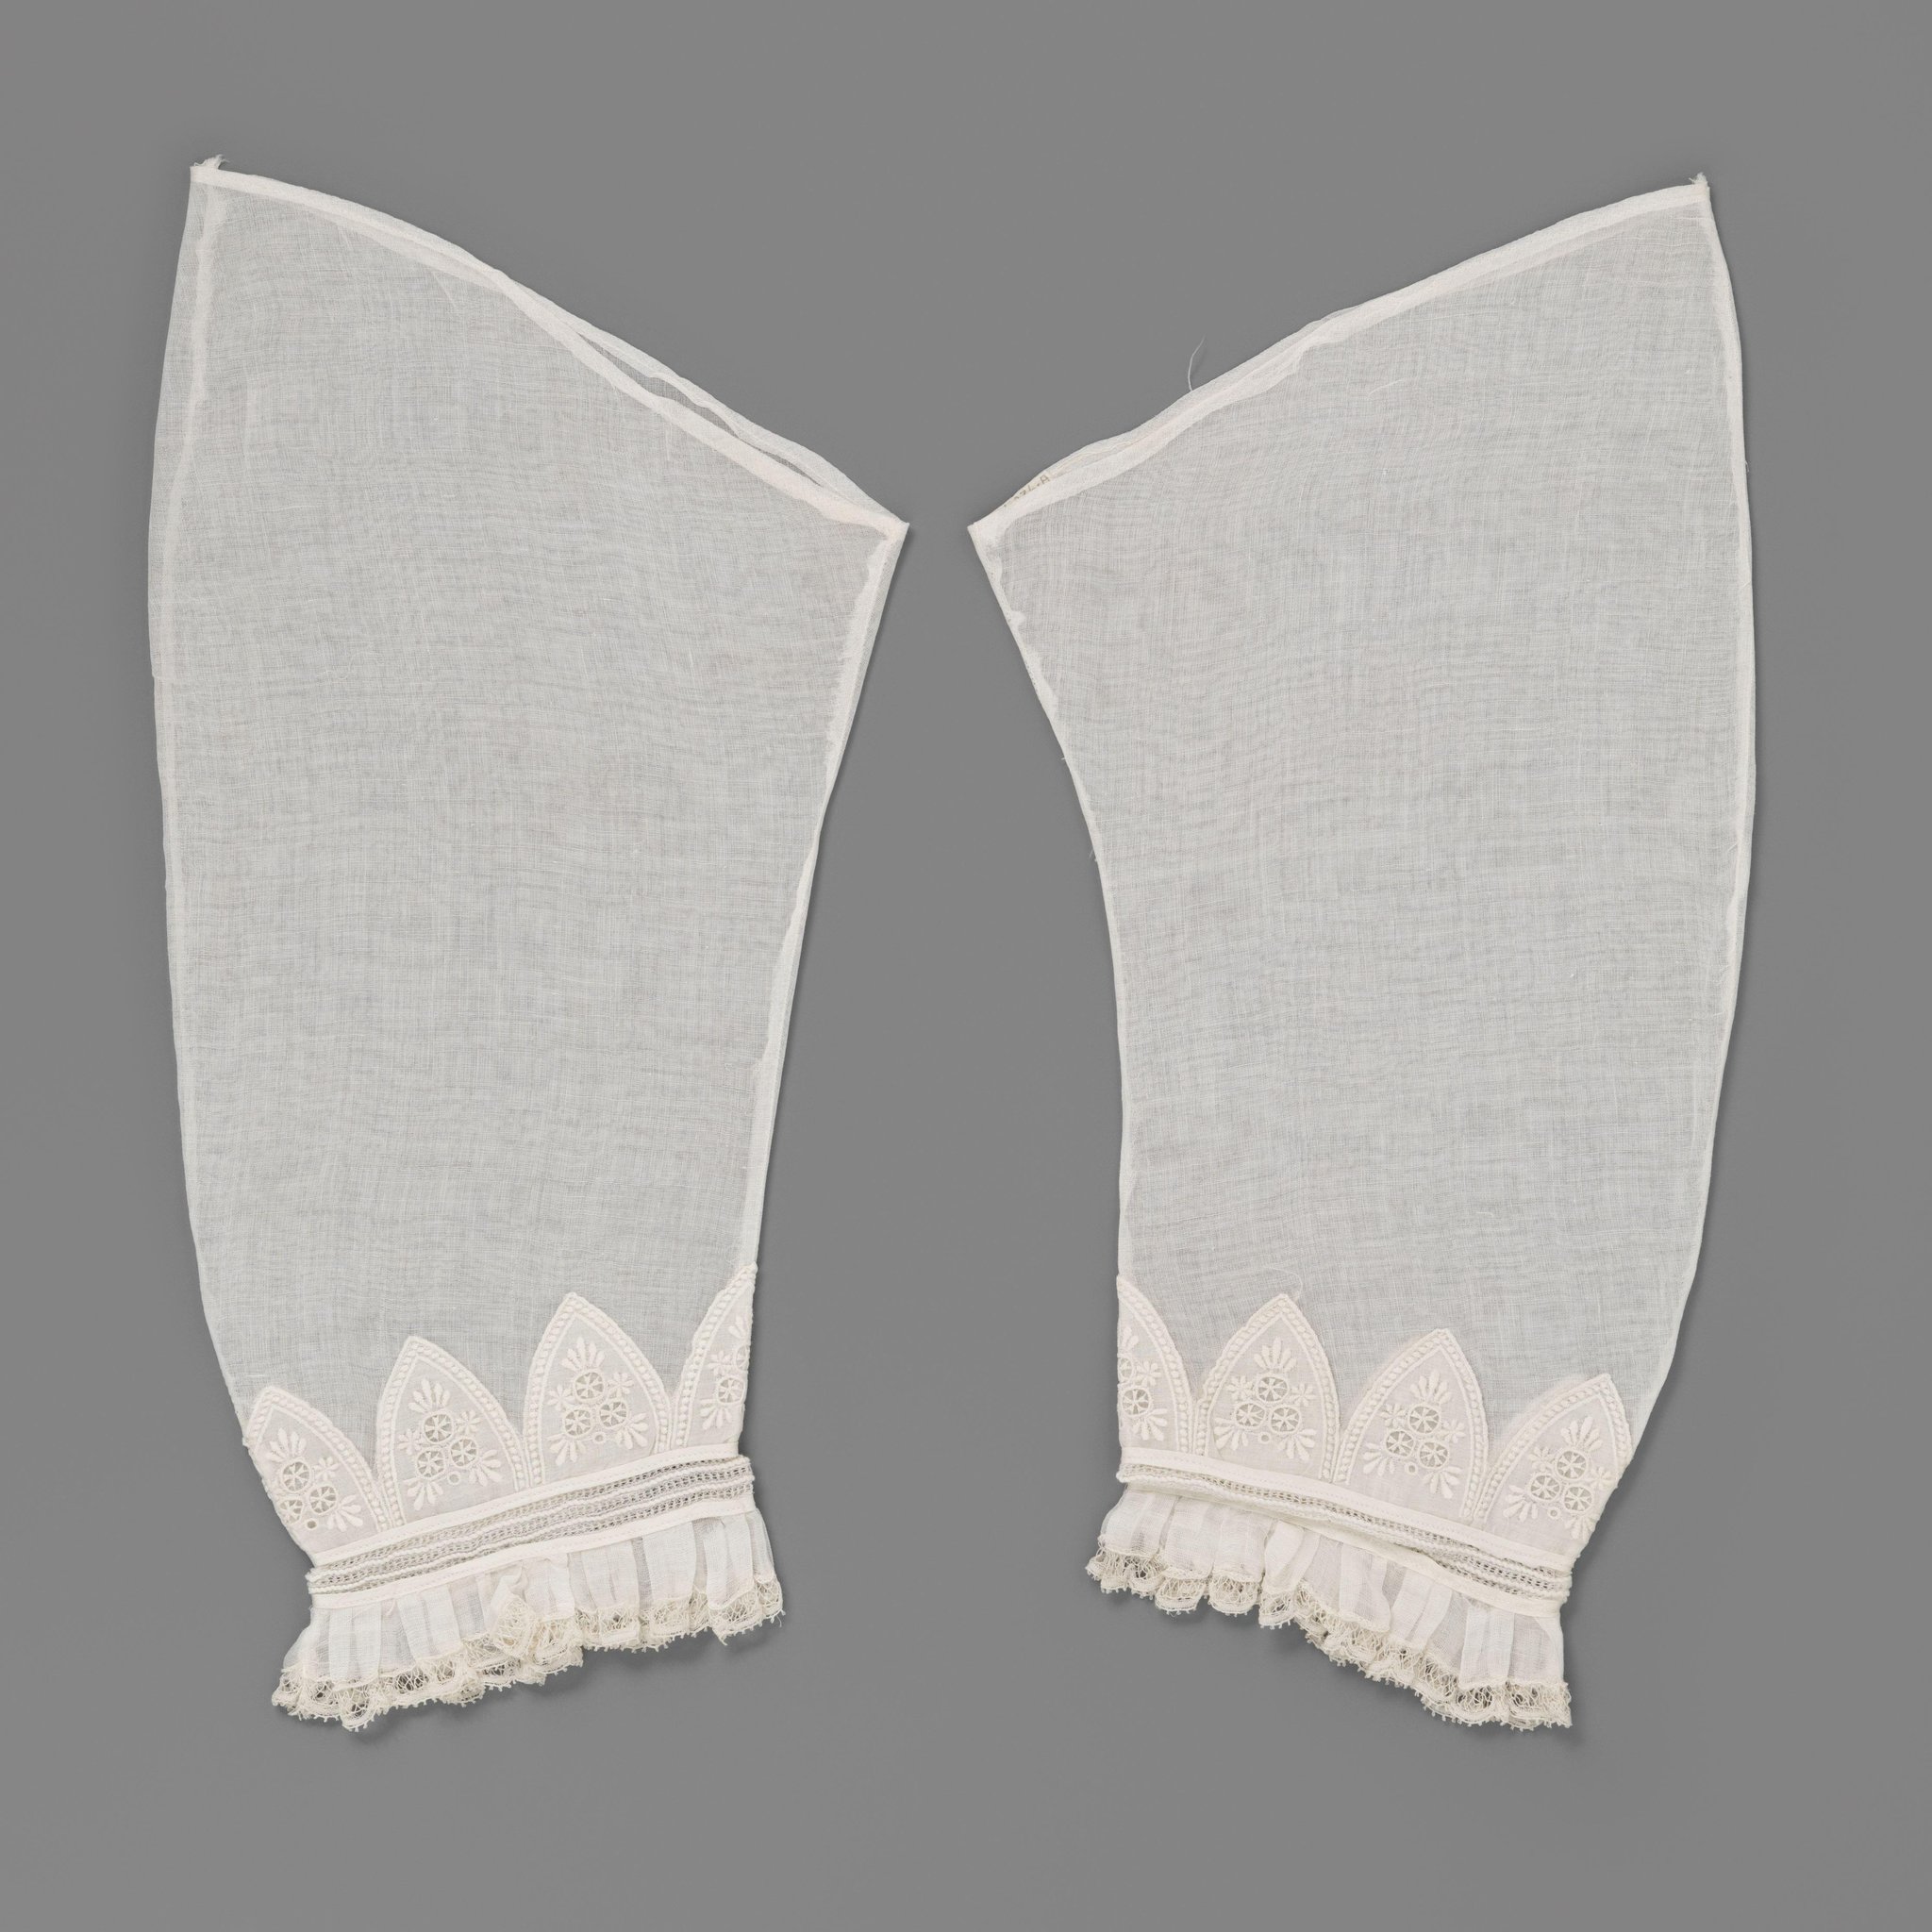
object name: womenswear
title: Ondermouw van glasbatist met borduurwerk en kant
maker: Anonymous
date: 1935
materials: textile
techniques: material, embroidered, lace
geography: western europe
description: Ondermouw van glasbatist met borduurwerk en kant. Glad model met rondgeknipte mouw en dichtgenaaide boorden. Opgenaaide schulpenstrook met sterren in cirkels, bloemen en palmetten. Geplooide strook van glasbatist met strook Valenciennes.